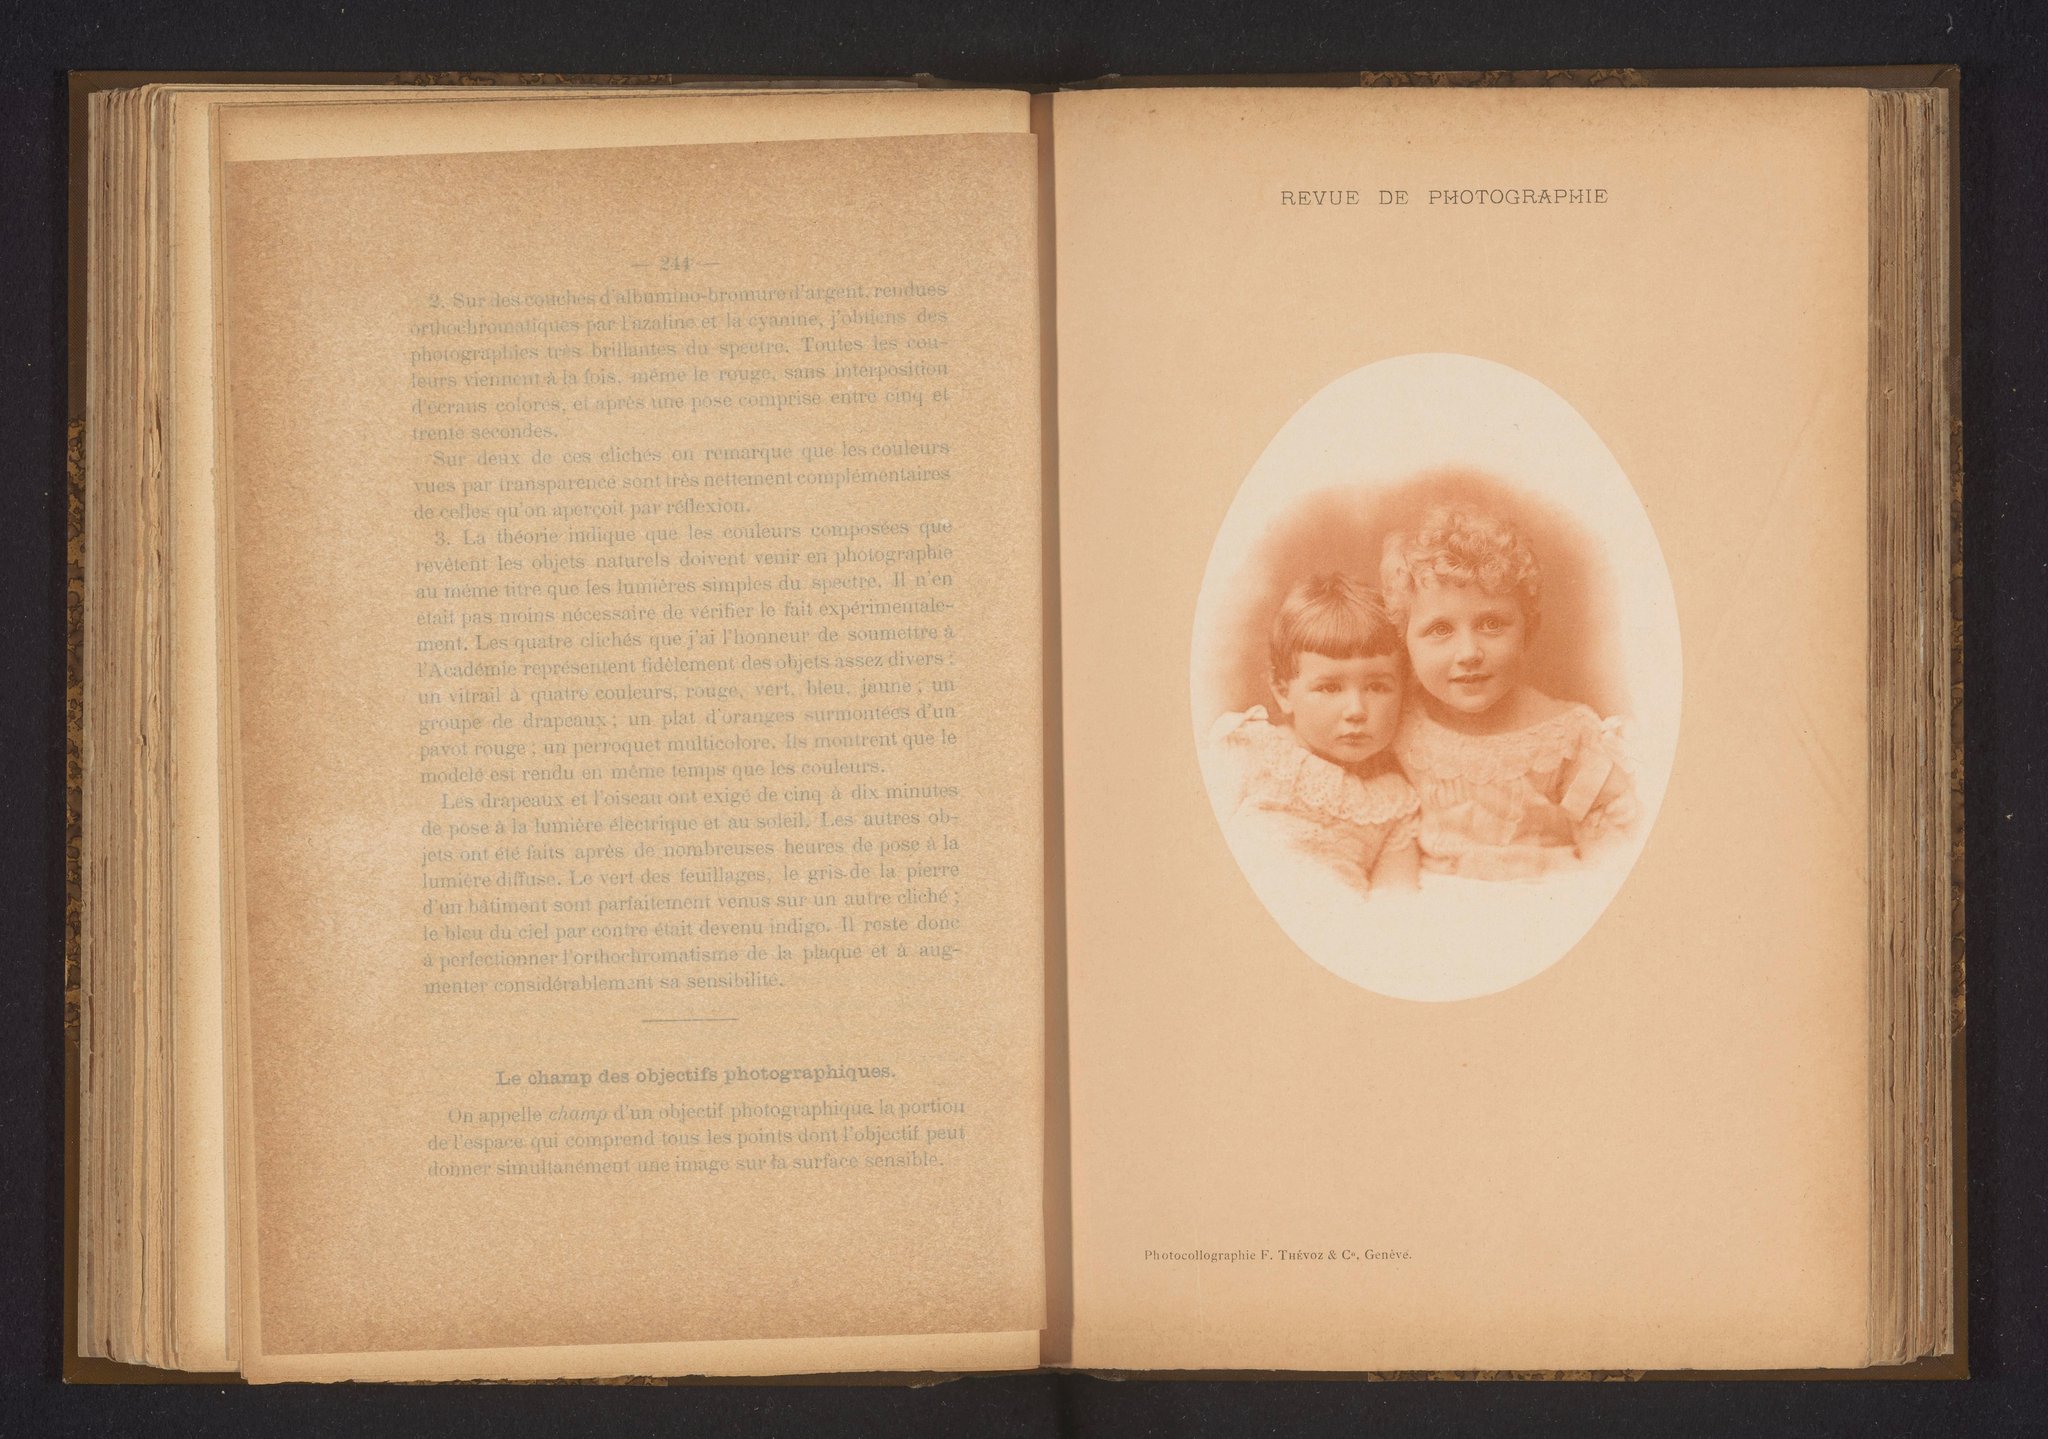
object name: photomechanical print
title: Portret van twee jonge onbekende kinderen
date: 1887-1892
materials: paper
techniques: photograph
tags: toddler, historical persons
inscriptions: inscription: ‘Revue de Photographie’